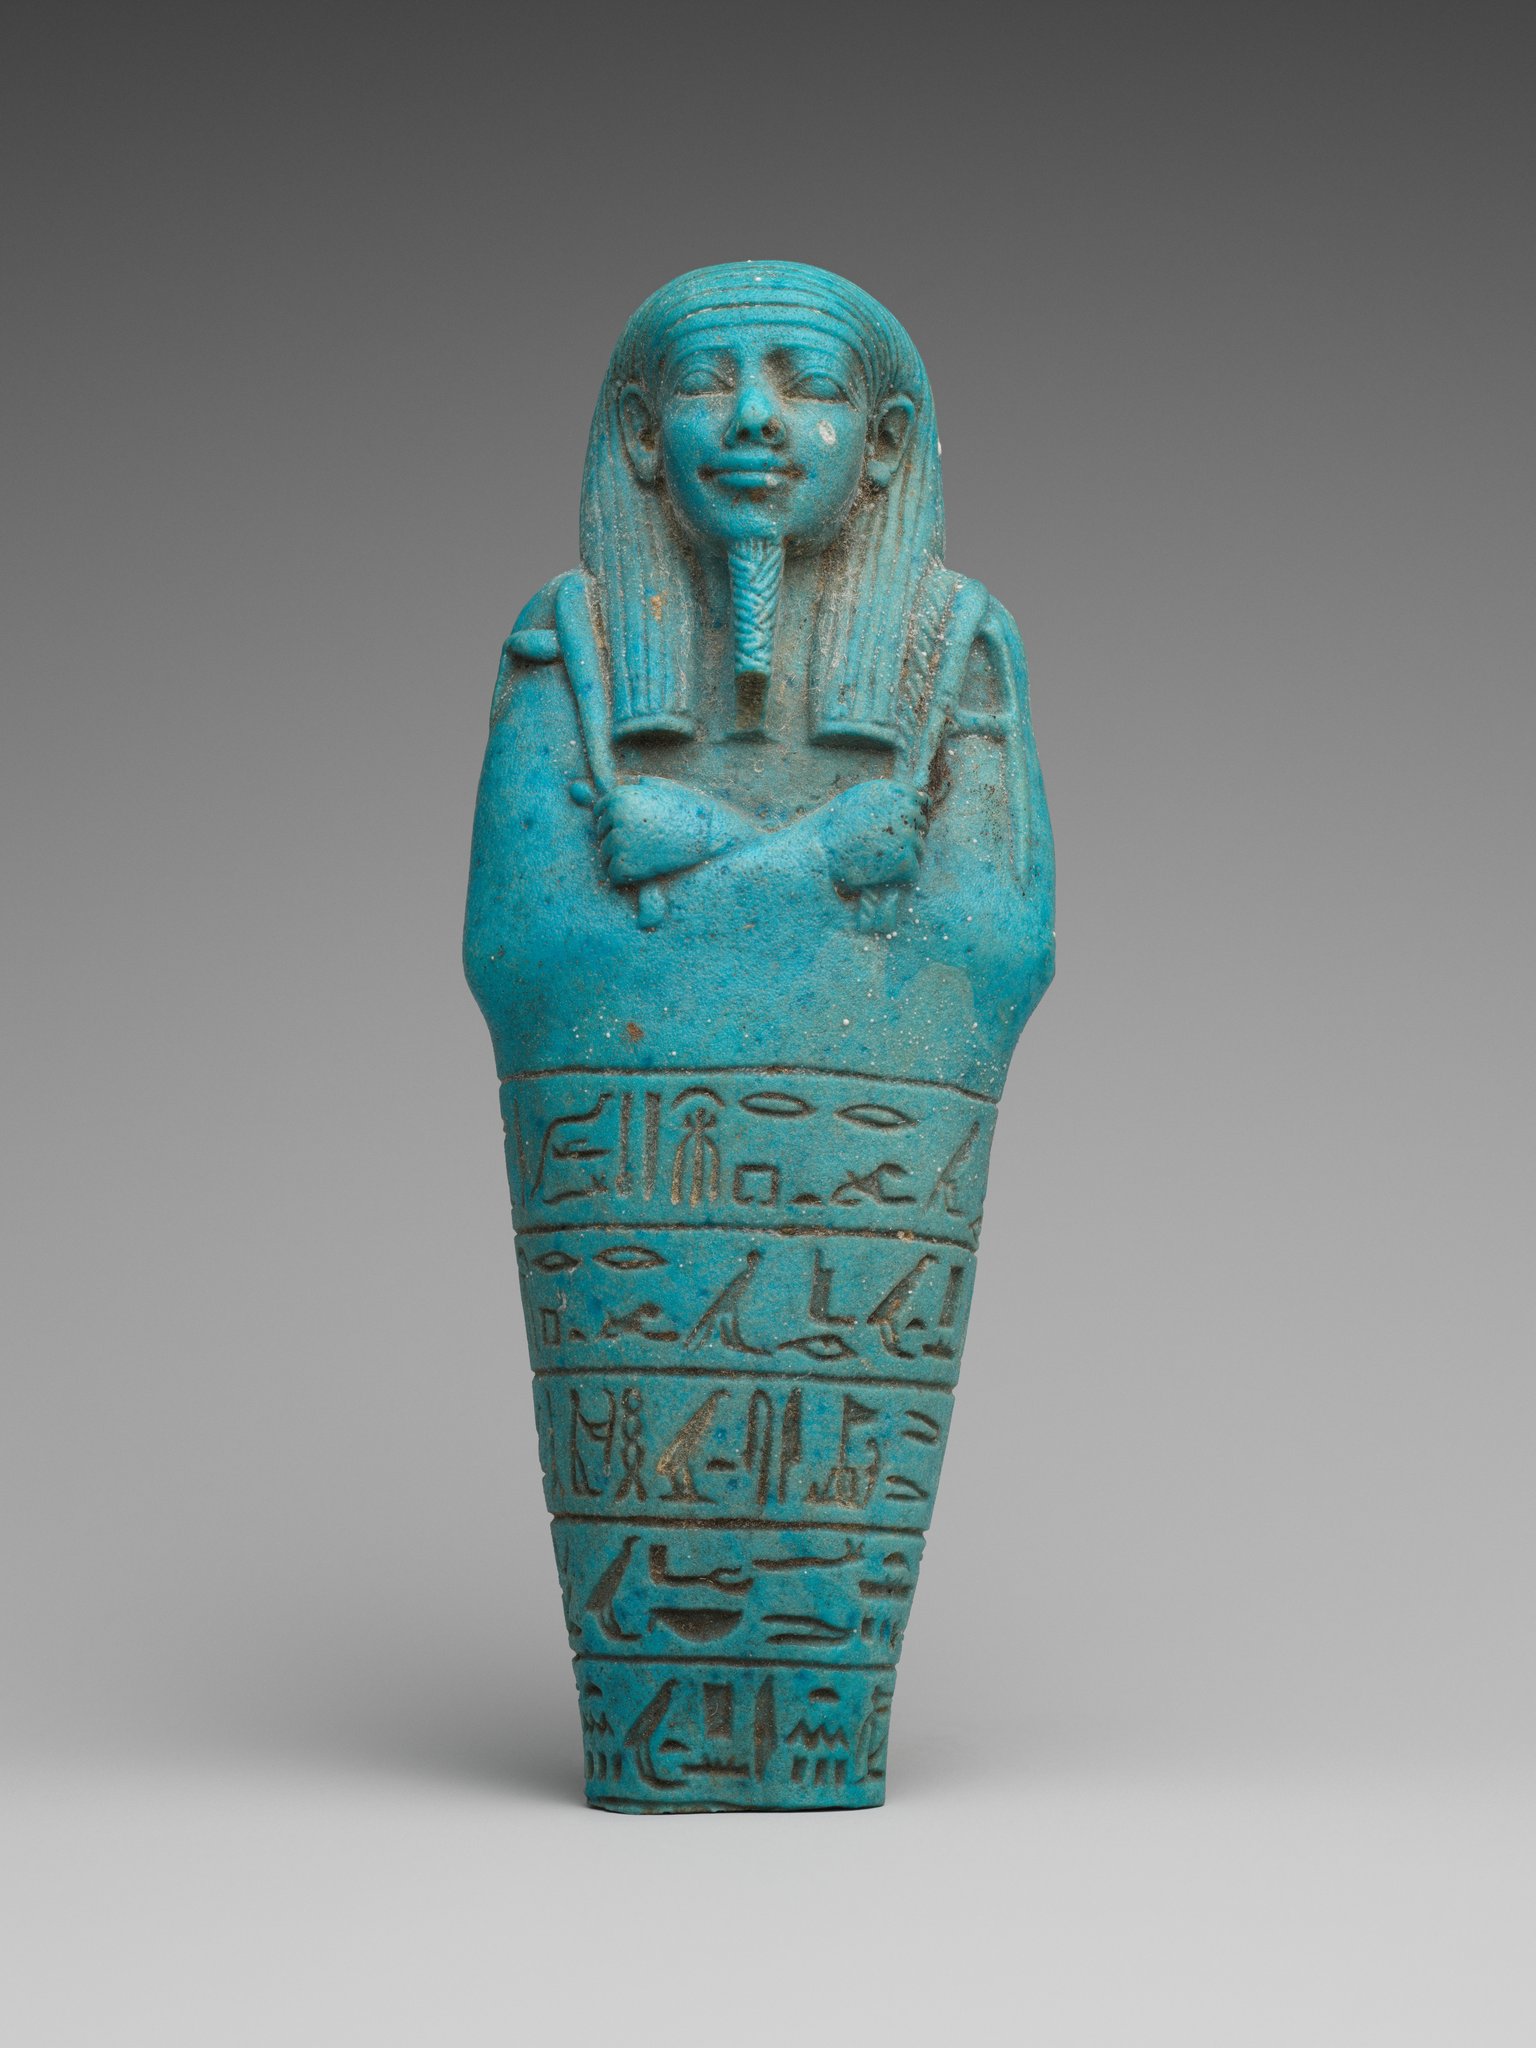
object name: worker shabti of ahmose, overseer of the portal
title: Shabti of the Overseer of the Portal Ahmose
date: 664-525 BCE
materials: faience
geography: egypt